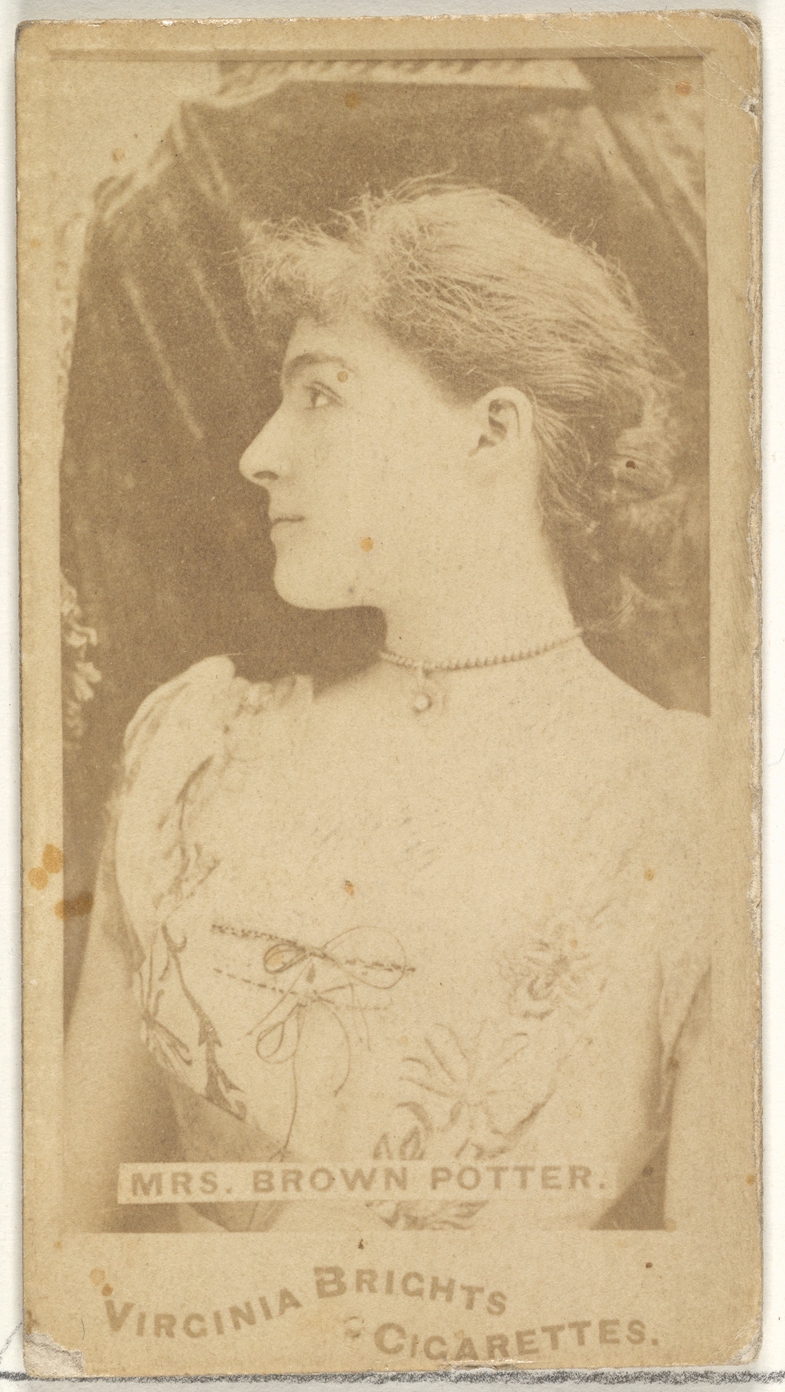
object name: photograph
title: Mrs. Brown Potter, from the Actors and Actresses series (N45, Type 1) for Virginia Brights Cigarettes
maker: allen & ginter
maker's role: publisher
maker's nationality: american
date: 1888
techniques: albumen silver print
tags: portraits,profiles,women,actresses